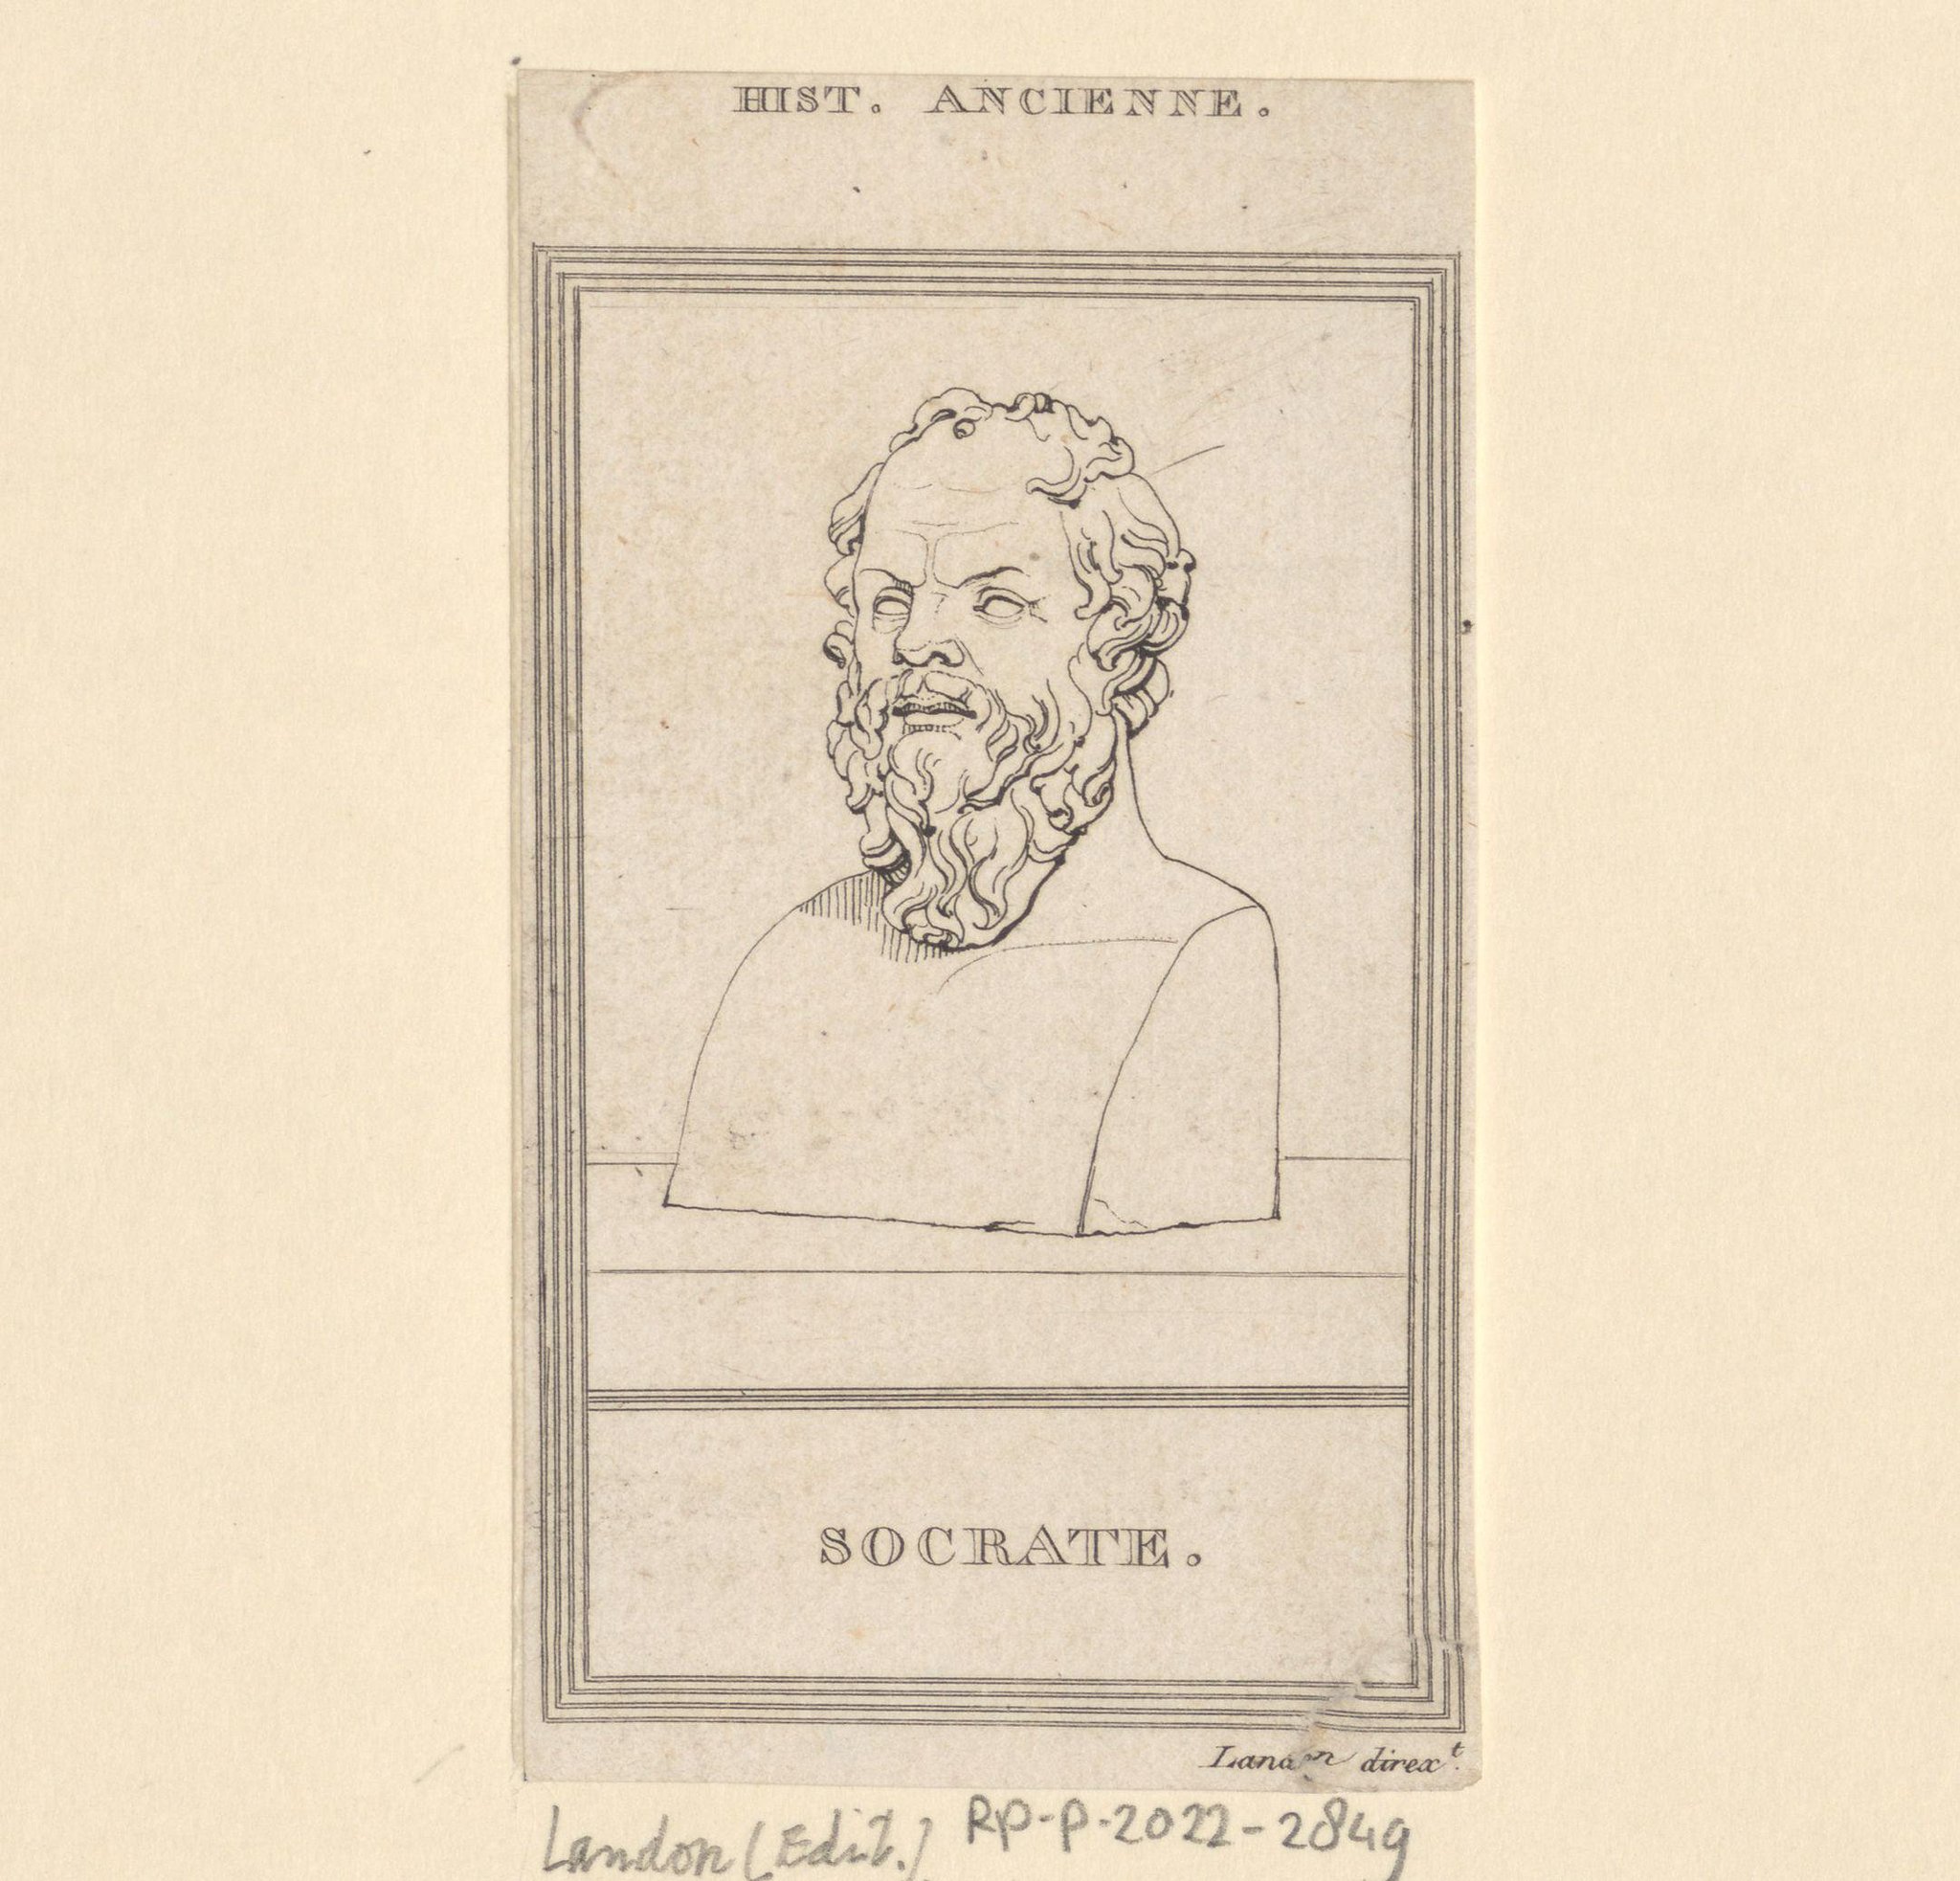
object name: print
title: Portret van Socrates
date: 1808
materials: paper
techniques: etching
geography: london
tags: scholar, philosopher, historical persons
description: Prent waarschijnlijk uit: Landon, Charles Paul. Galerie historique des hommes les plus célèbres (...). Parijs: Imprimerie des Annales du Musée, 1808, dl. 9.